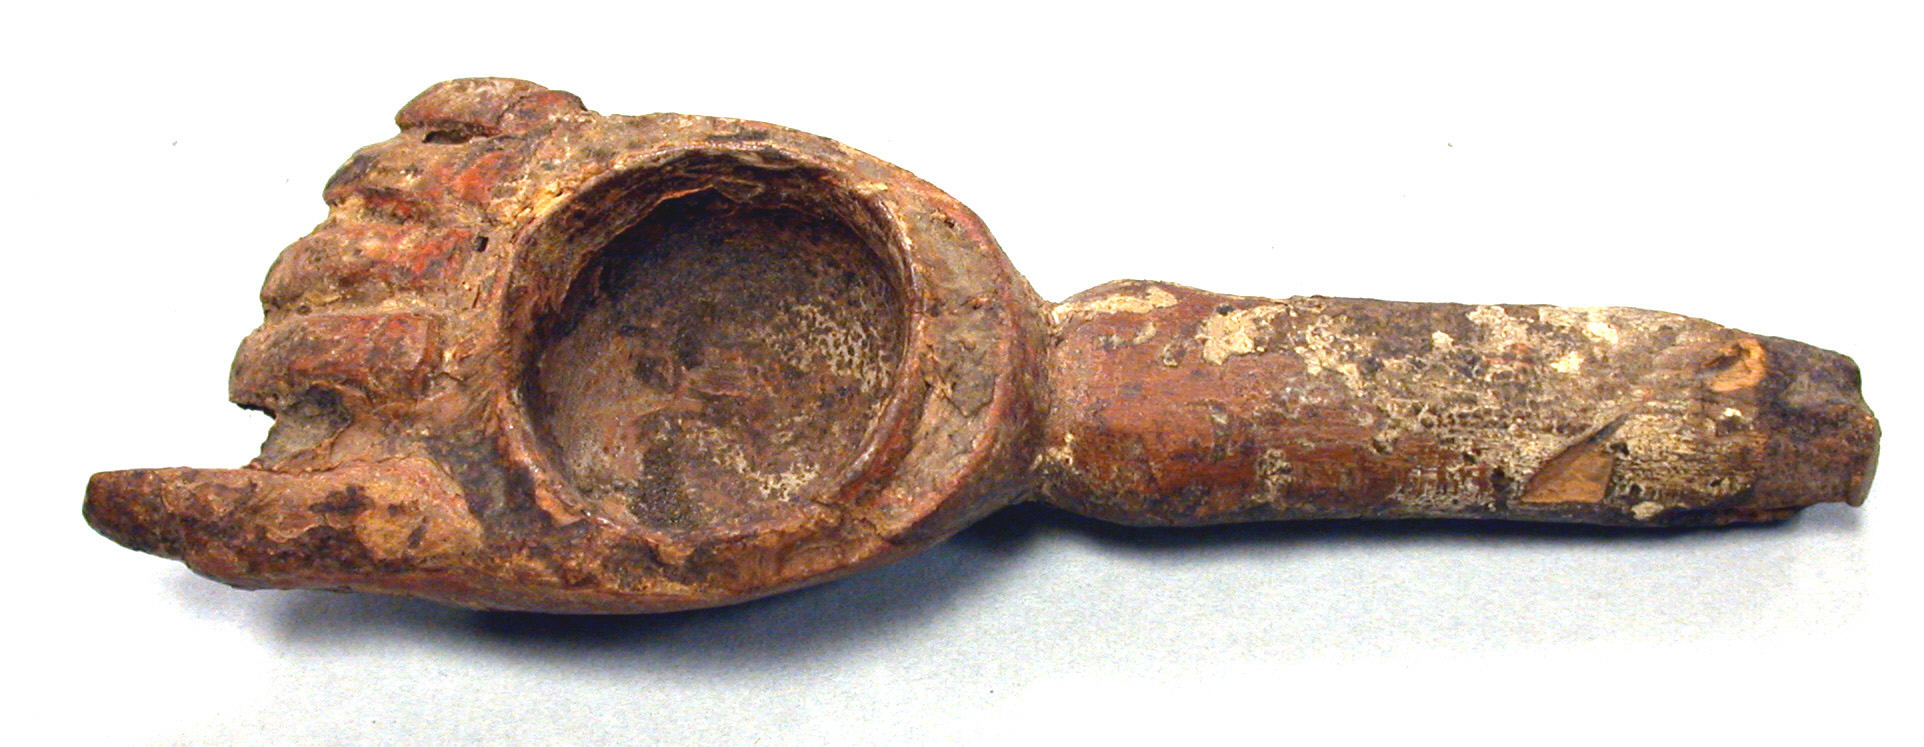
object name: vessel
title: Wooden Vessel in the Shape of a Hand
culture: peruvian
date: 1501-1600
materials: pigment, wood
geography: peru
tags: hands